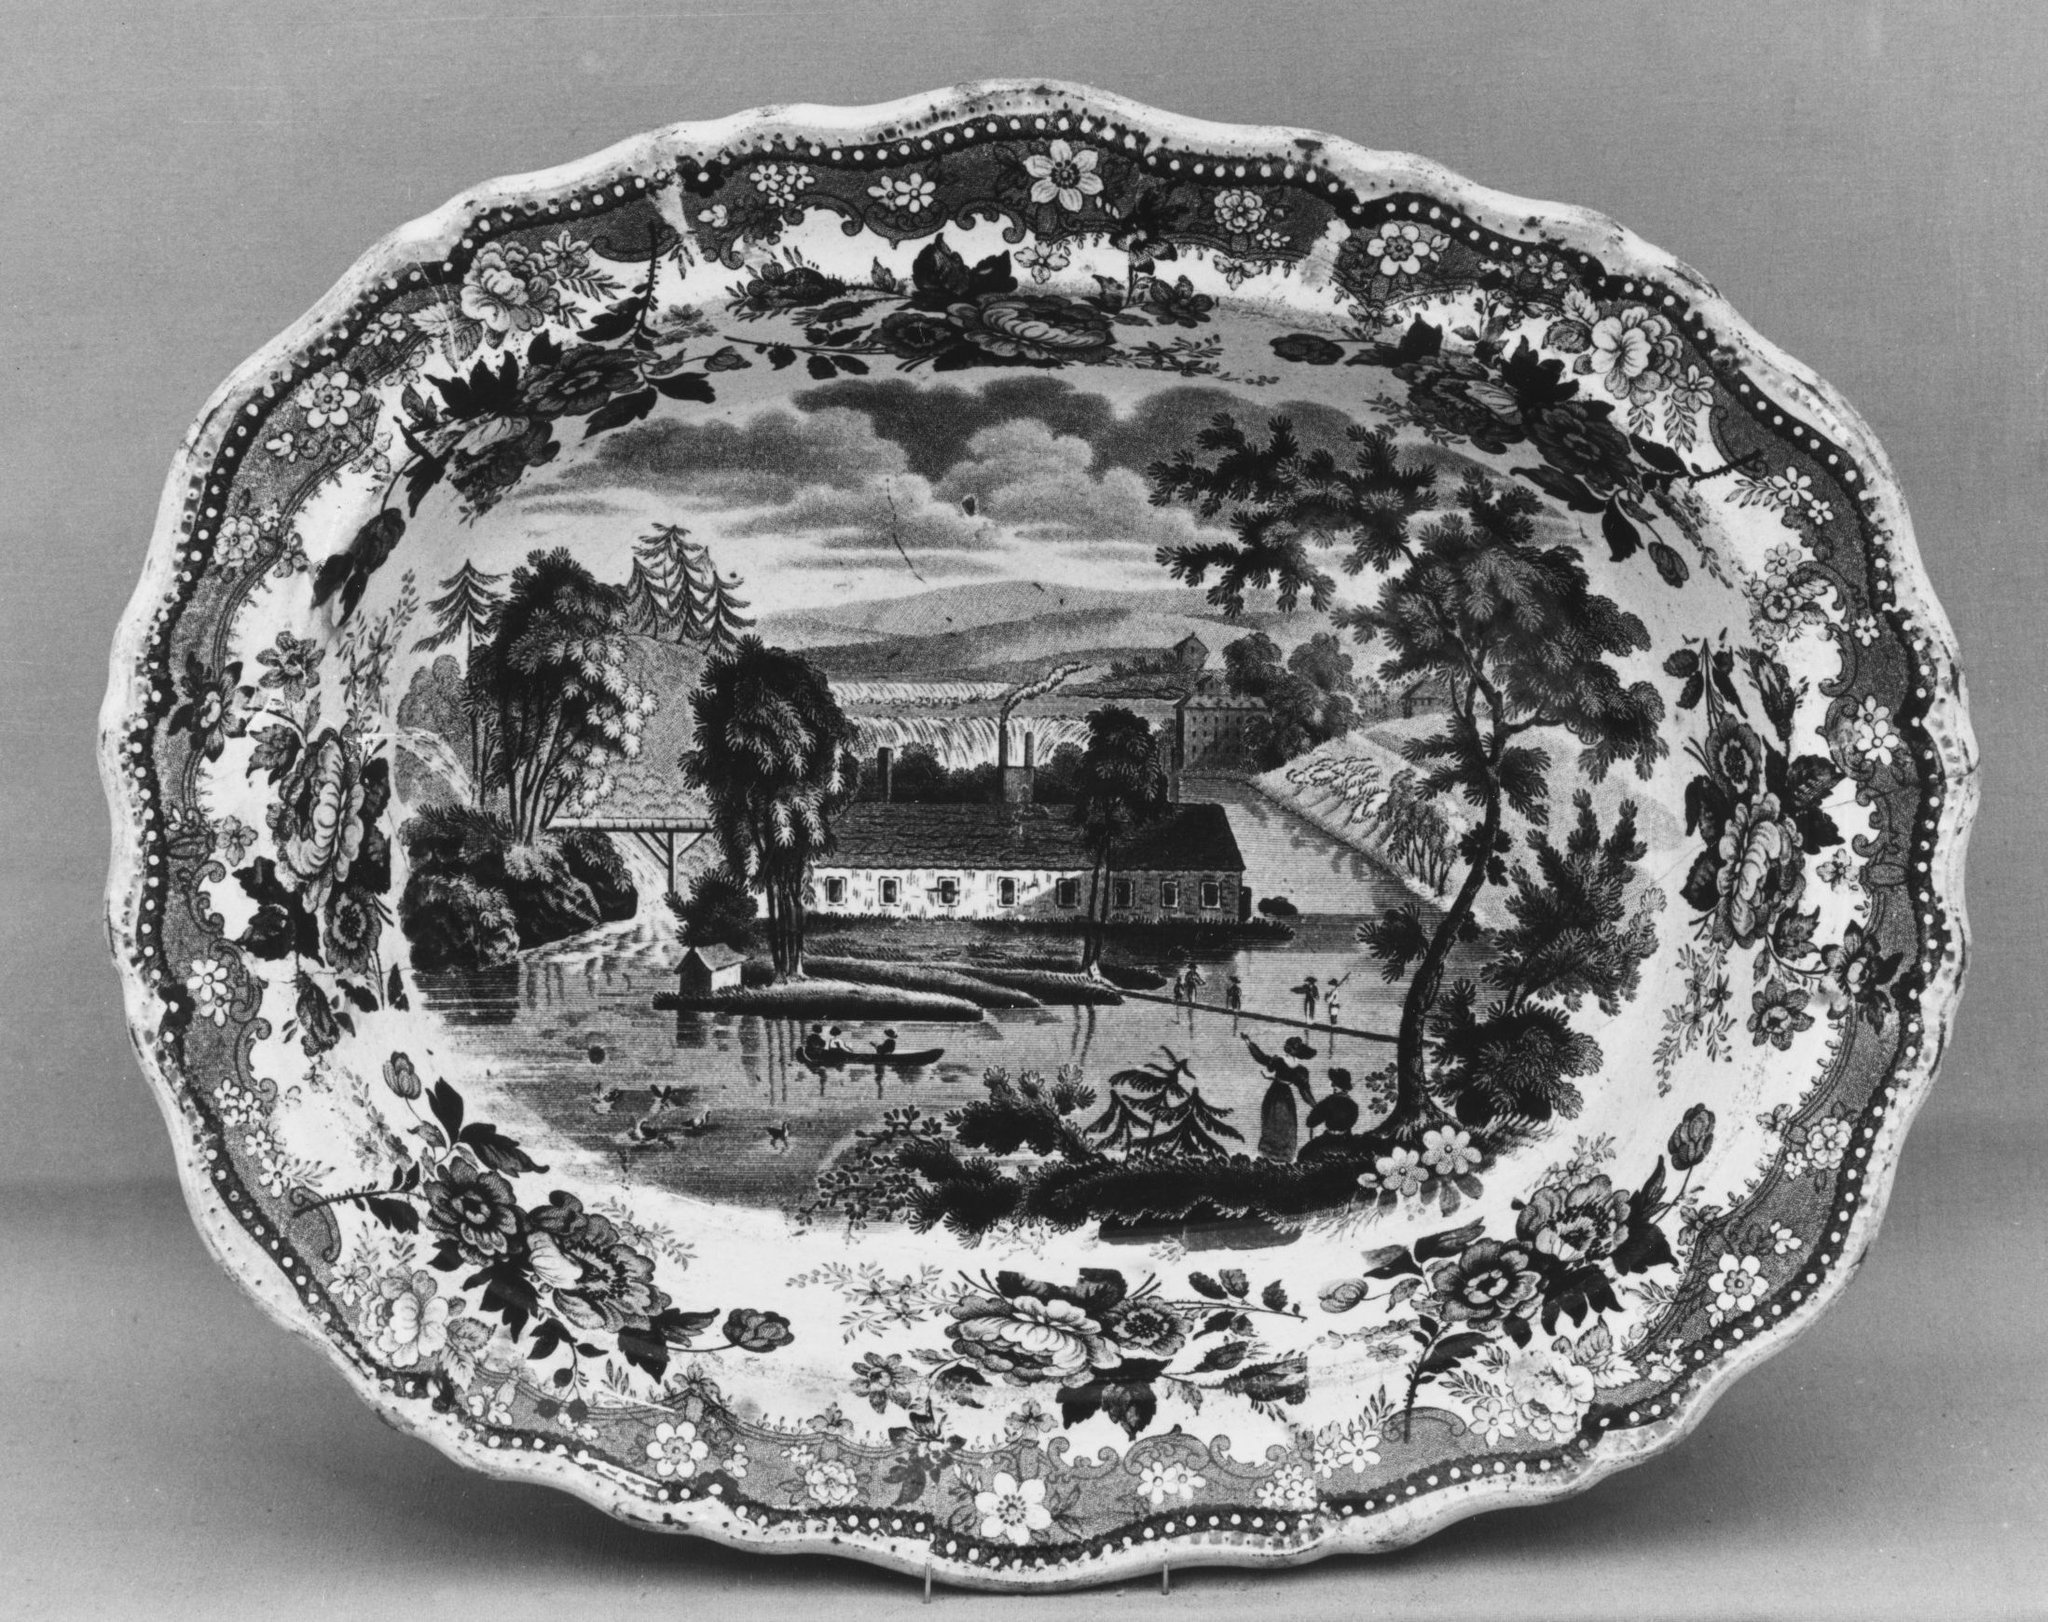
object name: dish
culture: british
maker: job & john jackson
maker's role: maker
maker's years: 1831-1835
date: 1831-1835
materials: earthenware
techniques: transfer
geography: england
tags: buildings,boats